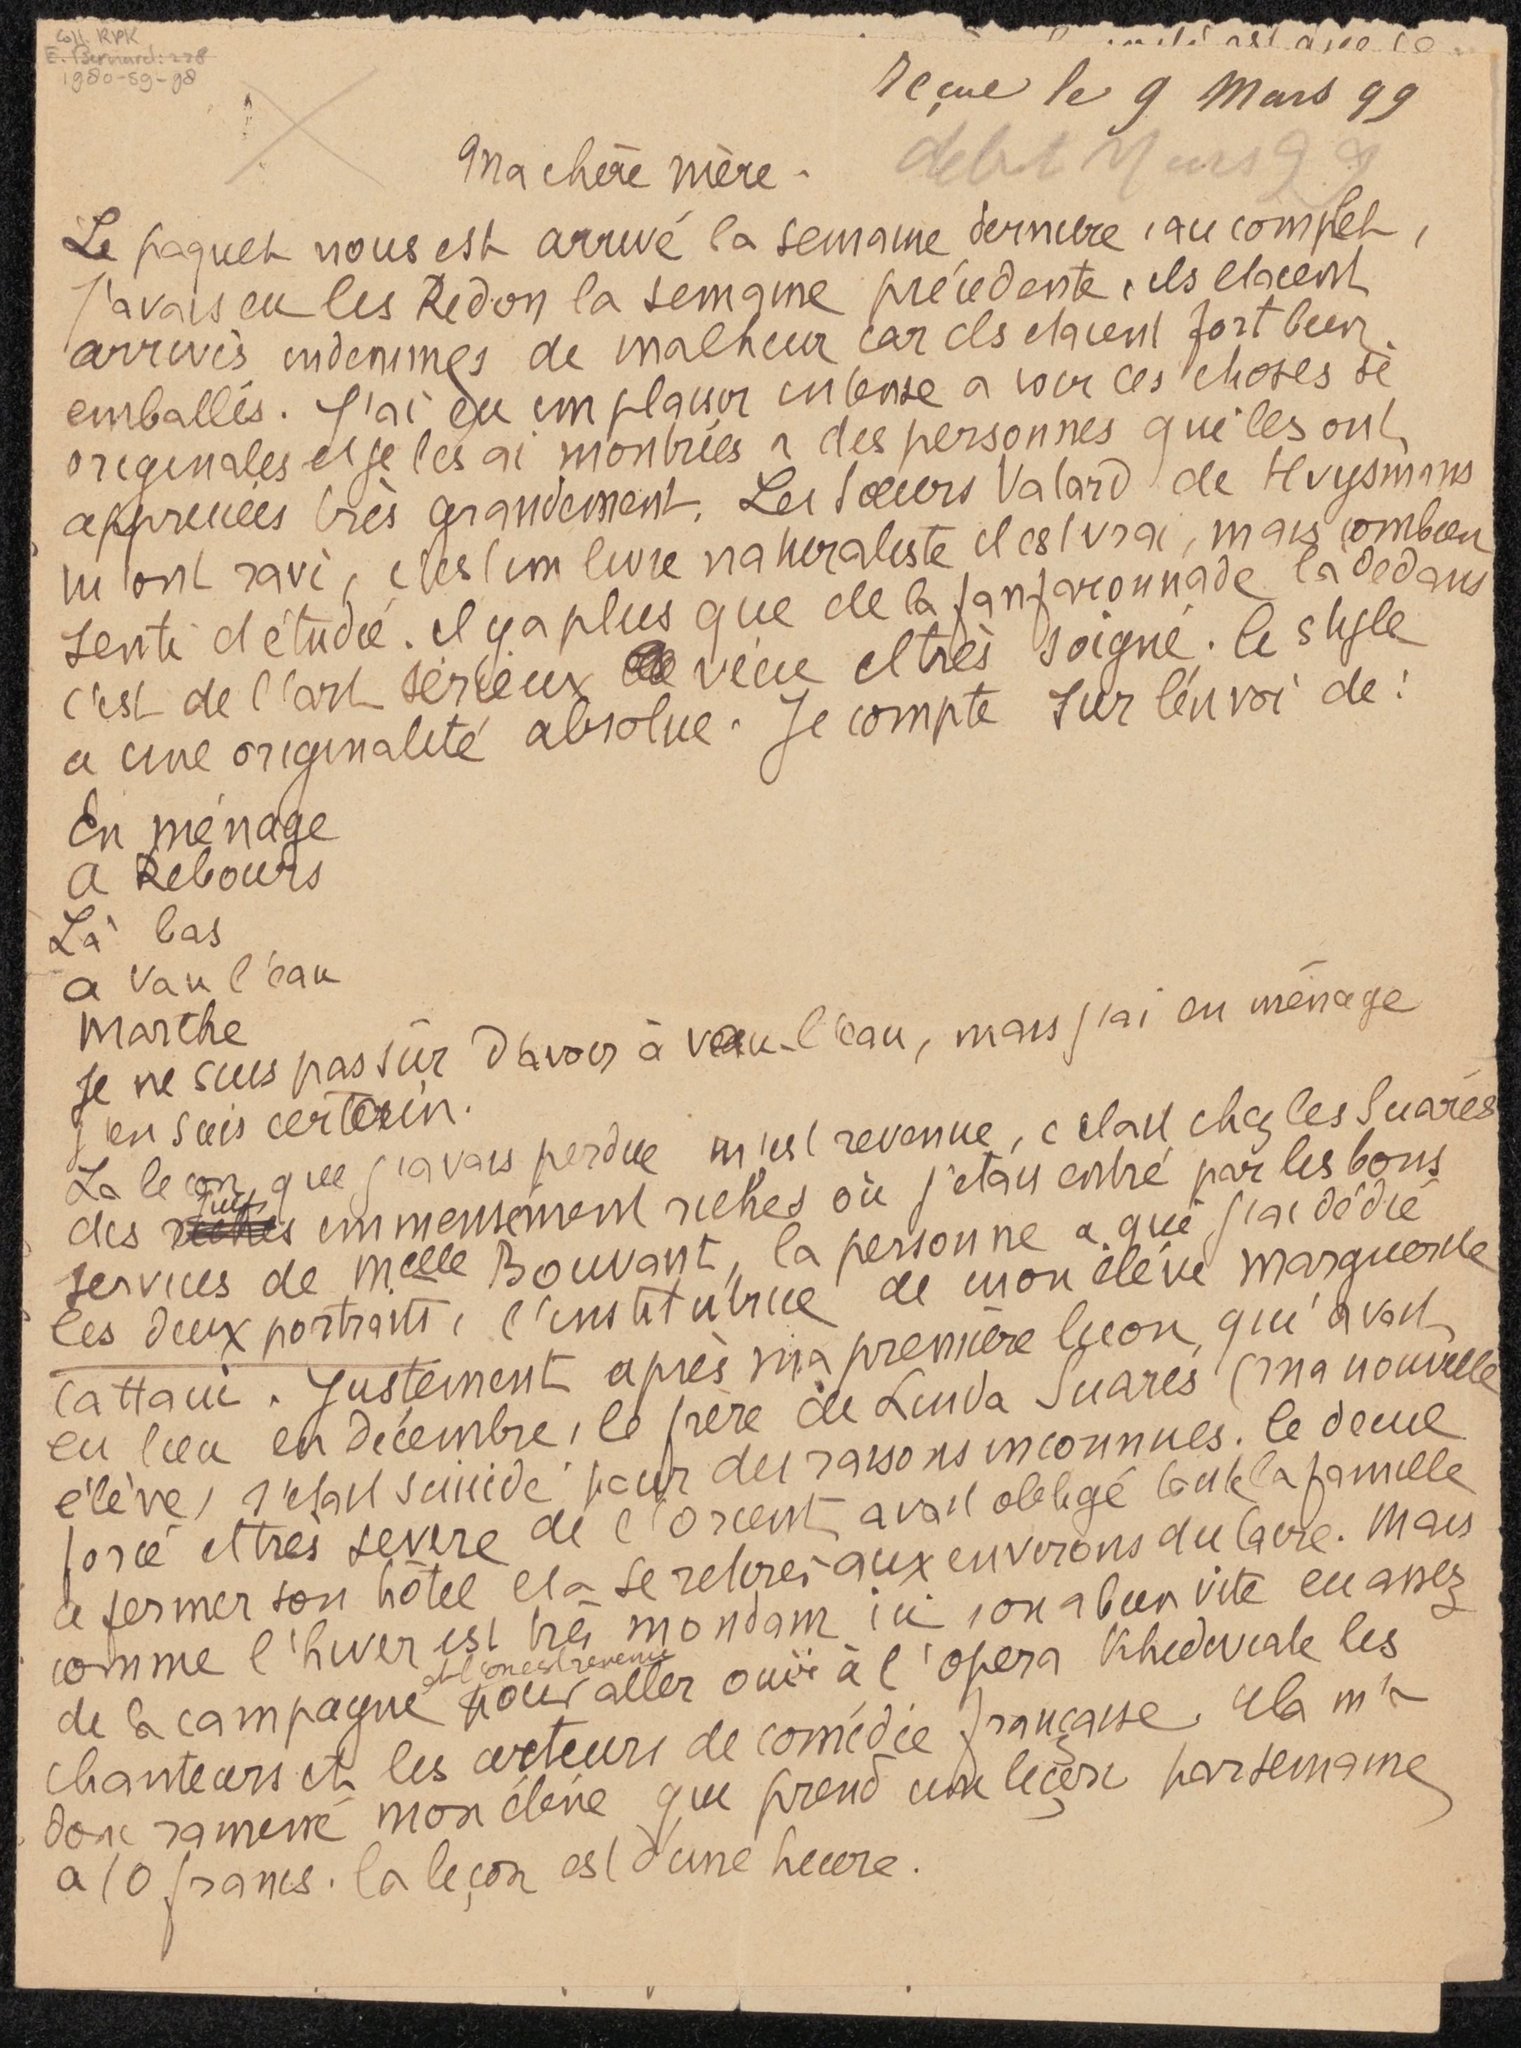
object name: letter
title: Brief aan Héloïse Bernard-Bodin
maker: émile bernard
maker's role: print maker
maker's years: 1868-1941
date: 1899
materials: ink, paper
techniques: pen, writing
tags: héloïse bernard-bodin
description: Brief gedateerd debut Mars 99 in latere hand.